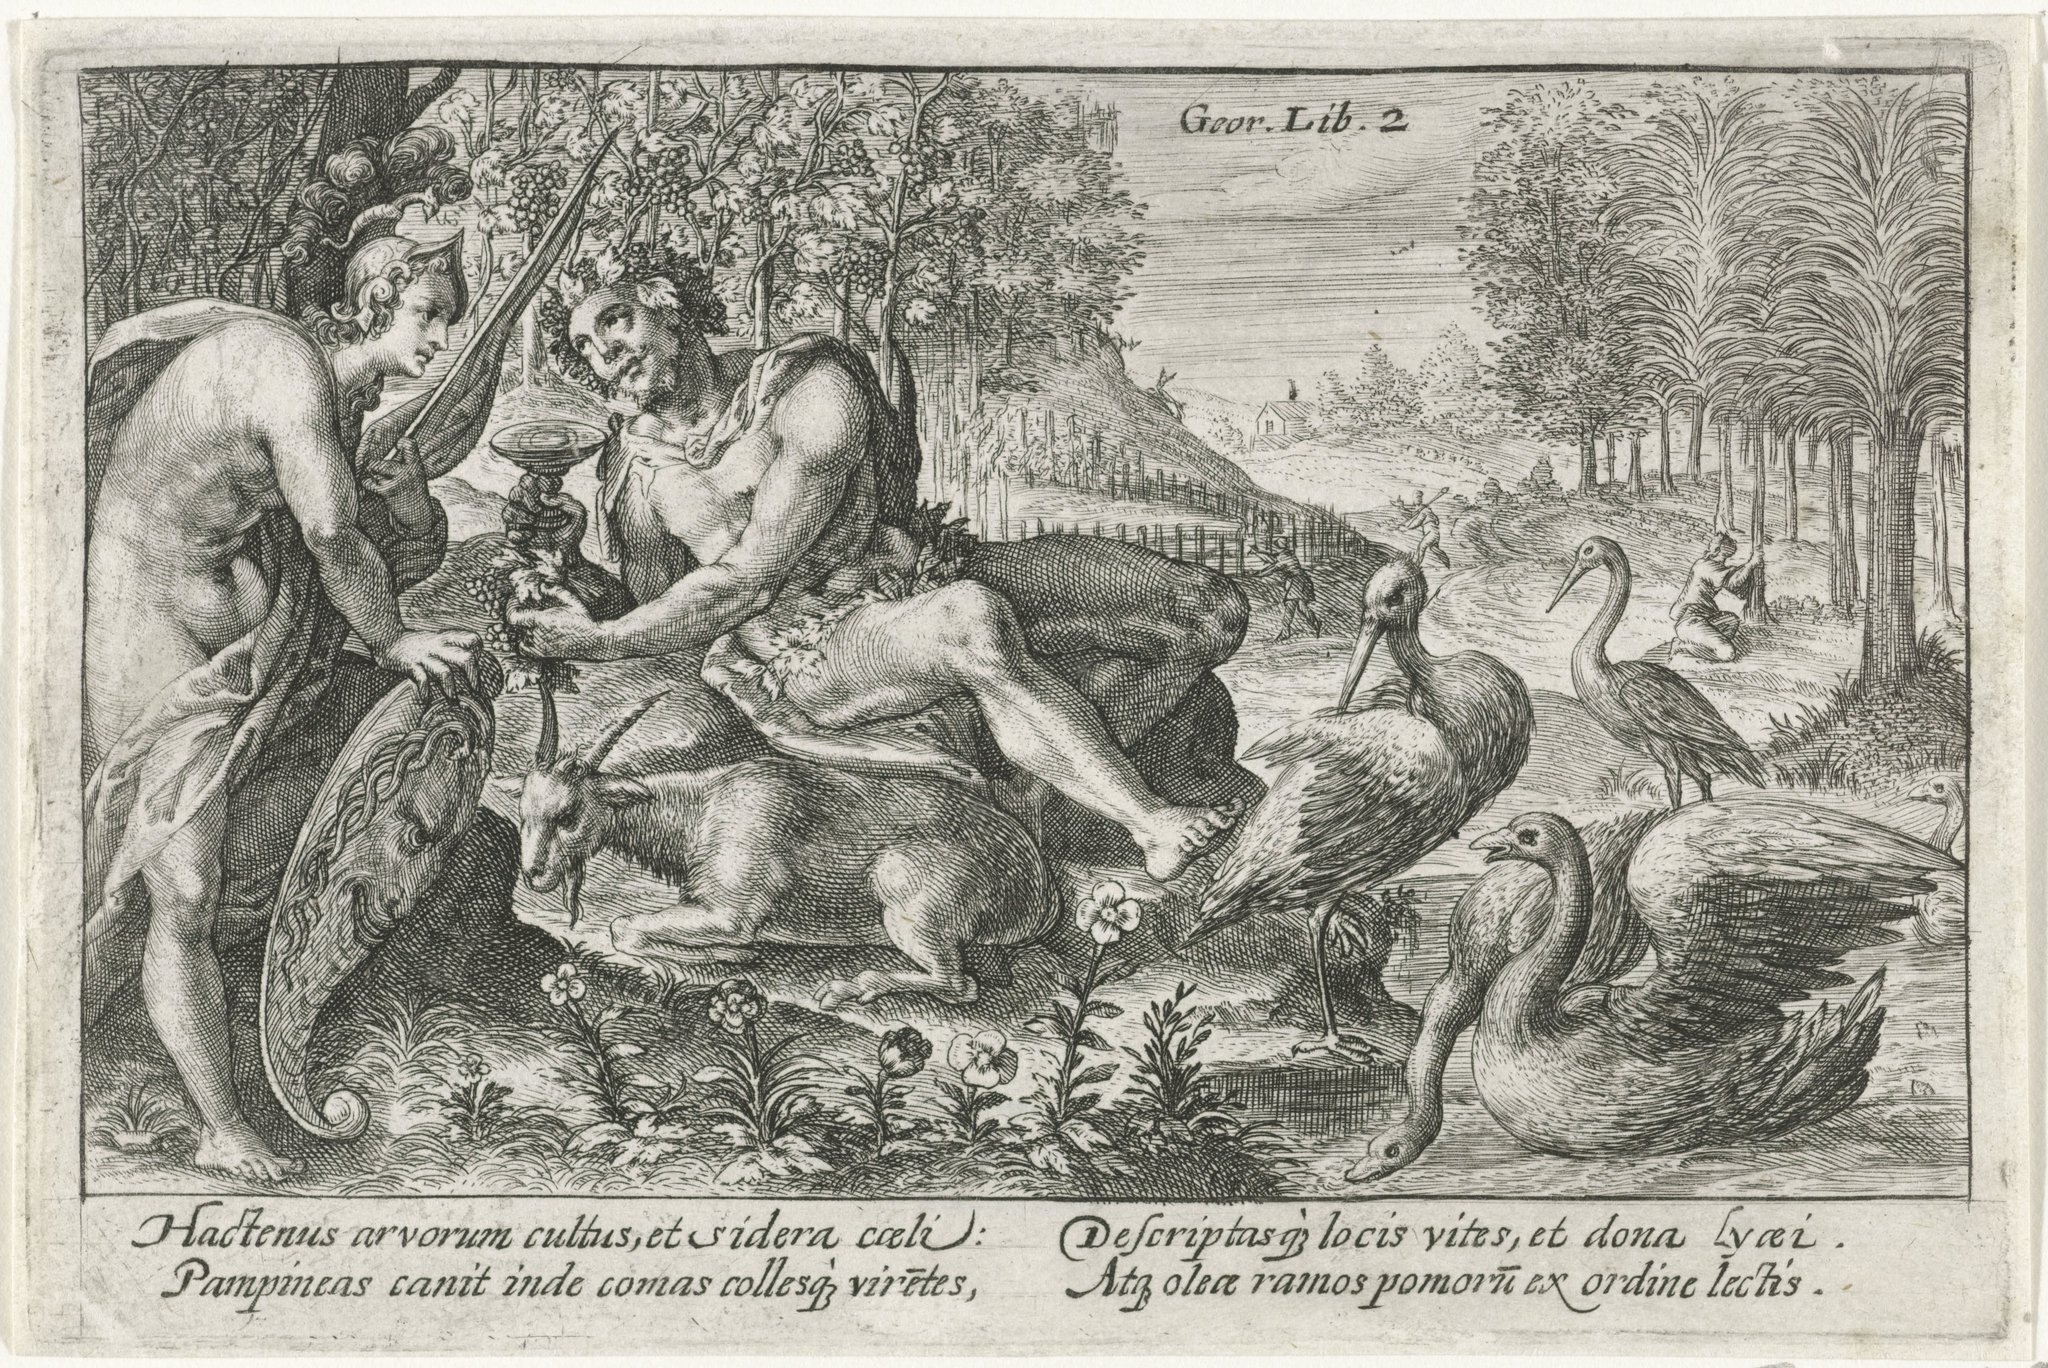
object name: print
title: Bacchus en Minerva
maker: crispijn van de passe (i)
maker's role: draughtsman, print maker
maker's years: 1564-1637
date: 1612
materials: paper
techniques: engraving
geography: utrecht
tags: specific aspects, allegorical aspects of bacchus; bacchus as patron, specific aspects, allegorical aspects of minerva; minerva as patroness, groups of animals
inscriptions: collector's mark: Lugt 2228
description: Landschap met Bacchus en Minerva, omringd door dieren. In de marge een vierregelig onderschrift, in twee kolommen, in het Latijn.